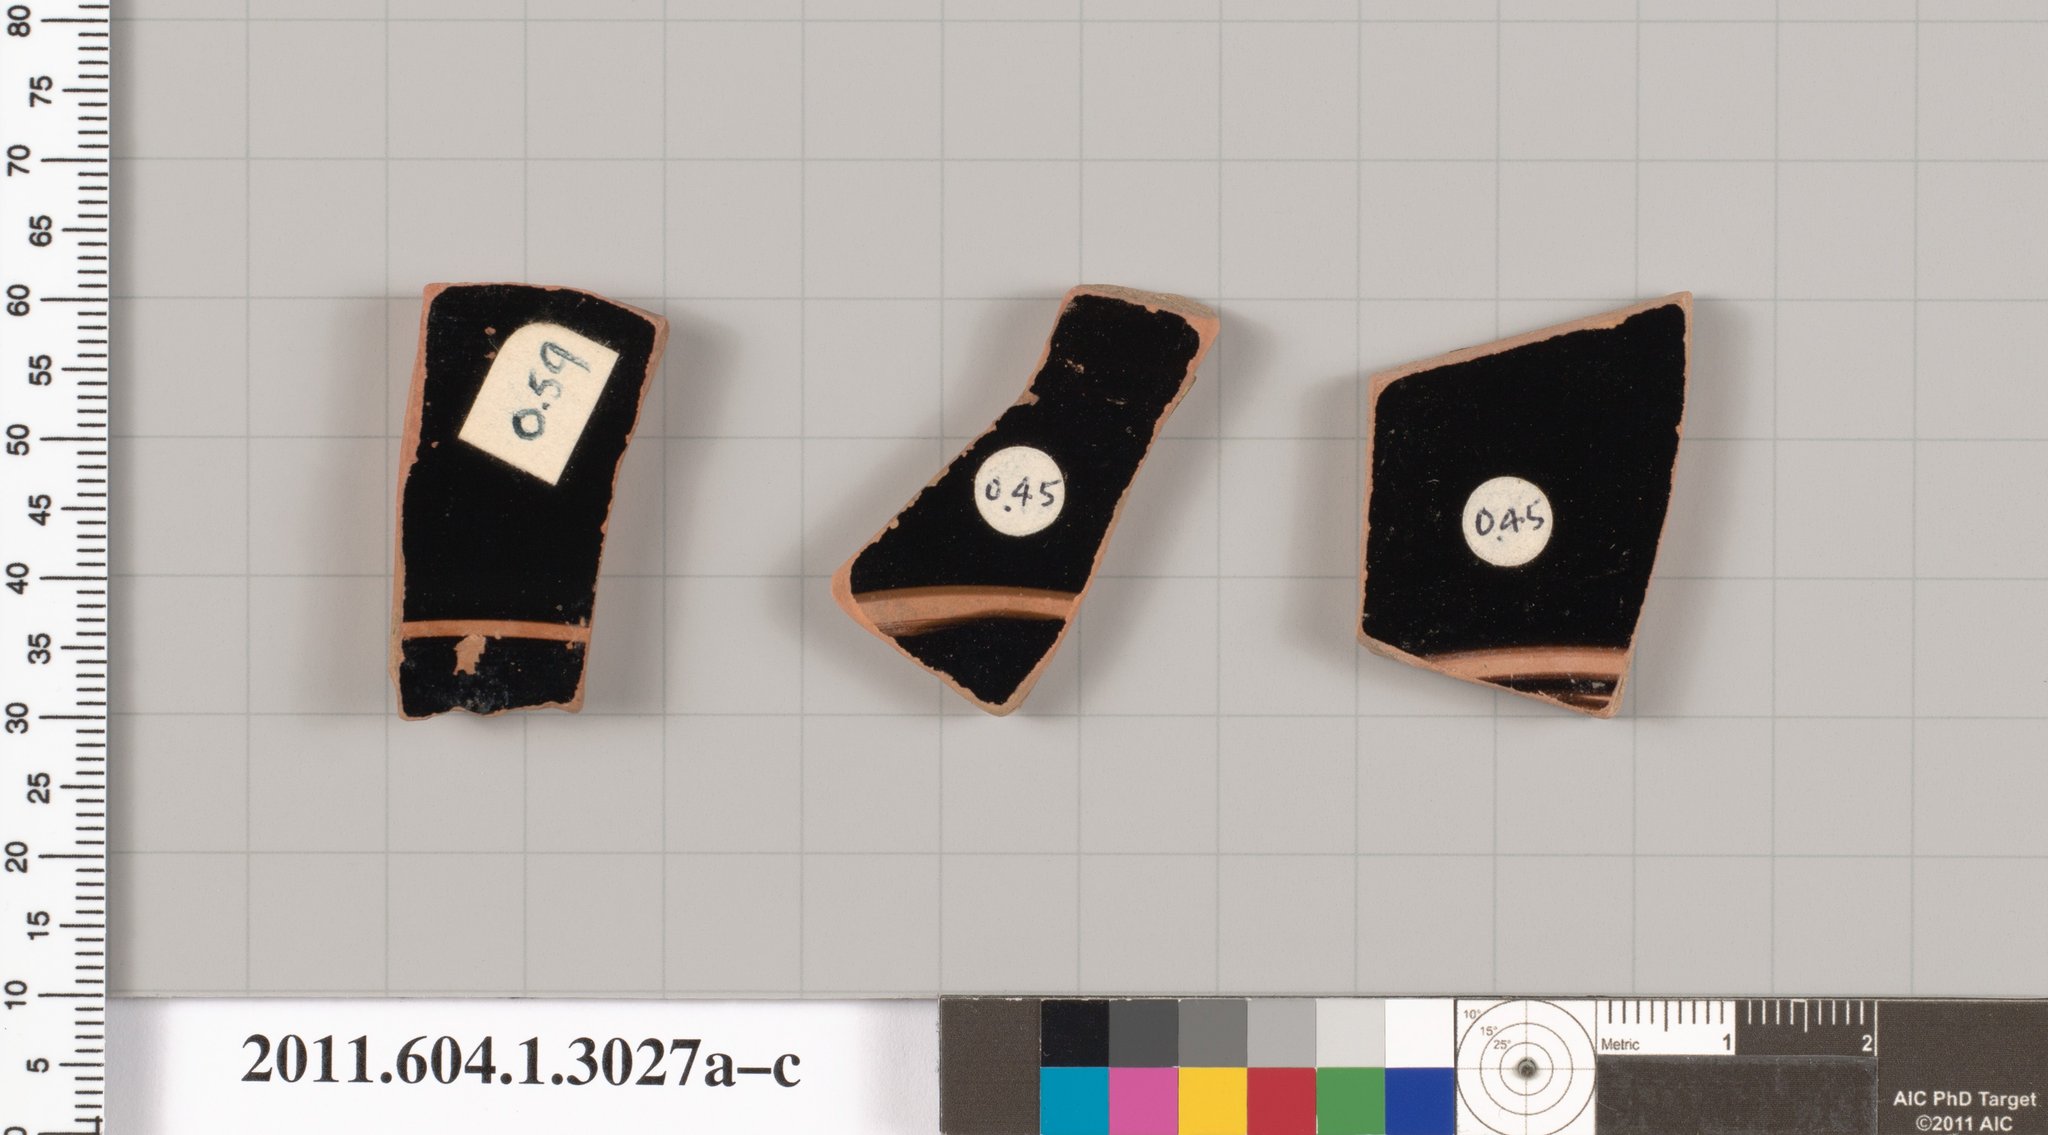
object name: kylix fragment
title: Terracotta fragments of kylikes (drinking cups)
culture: greek, attic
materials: terracotta